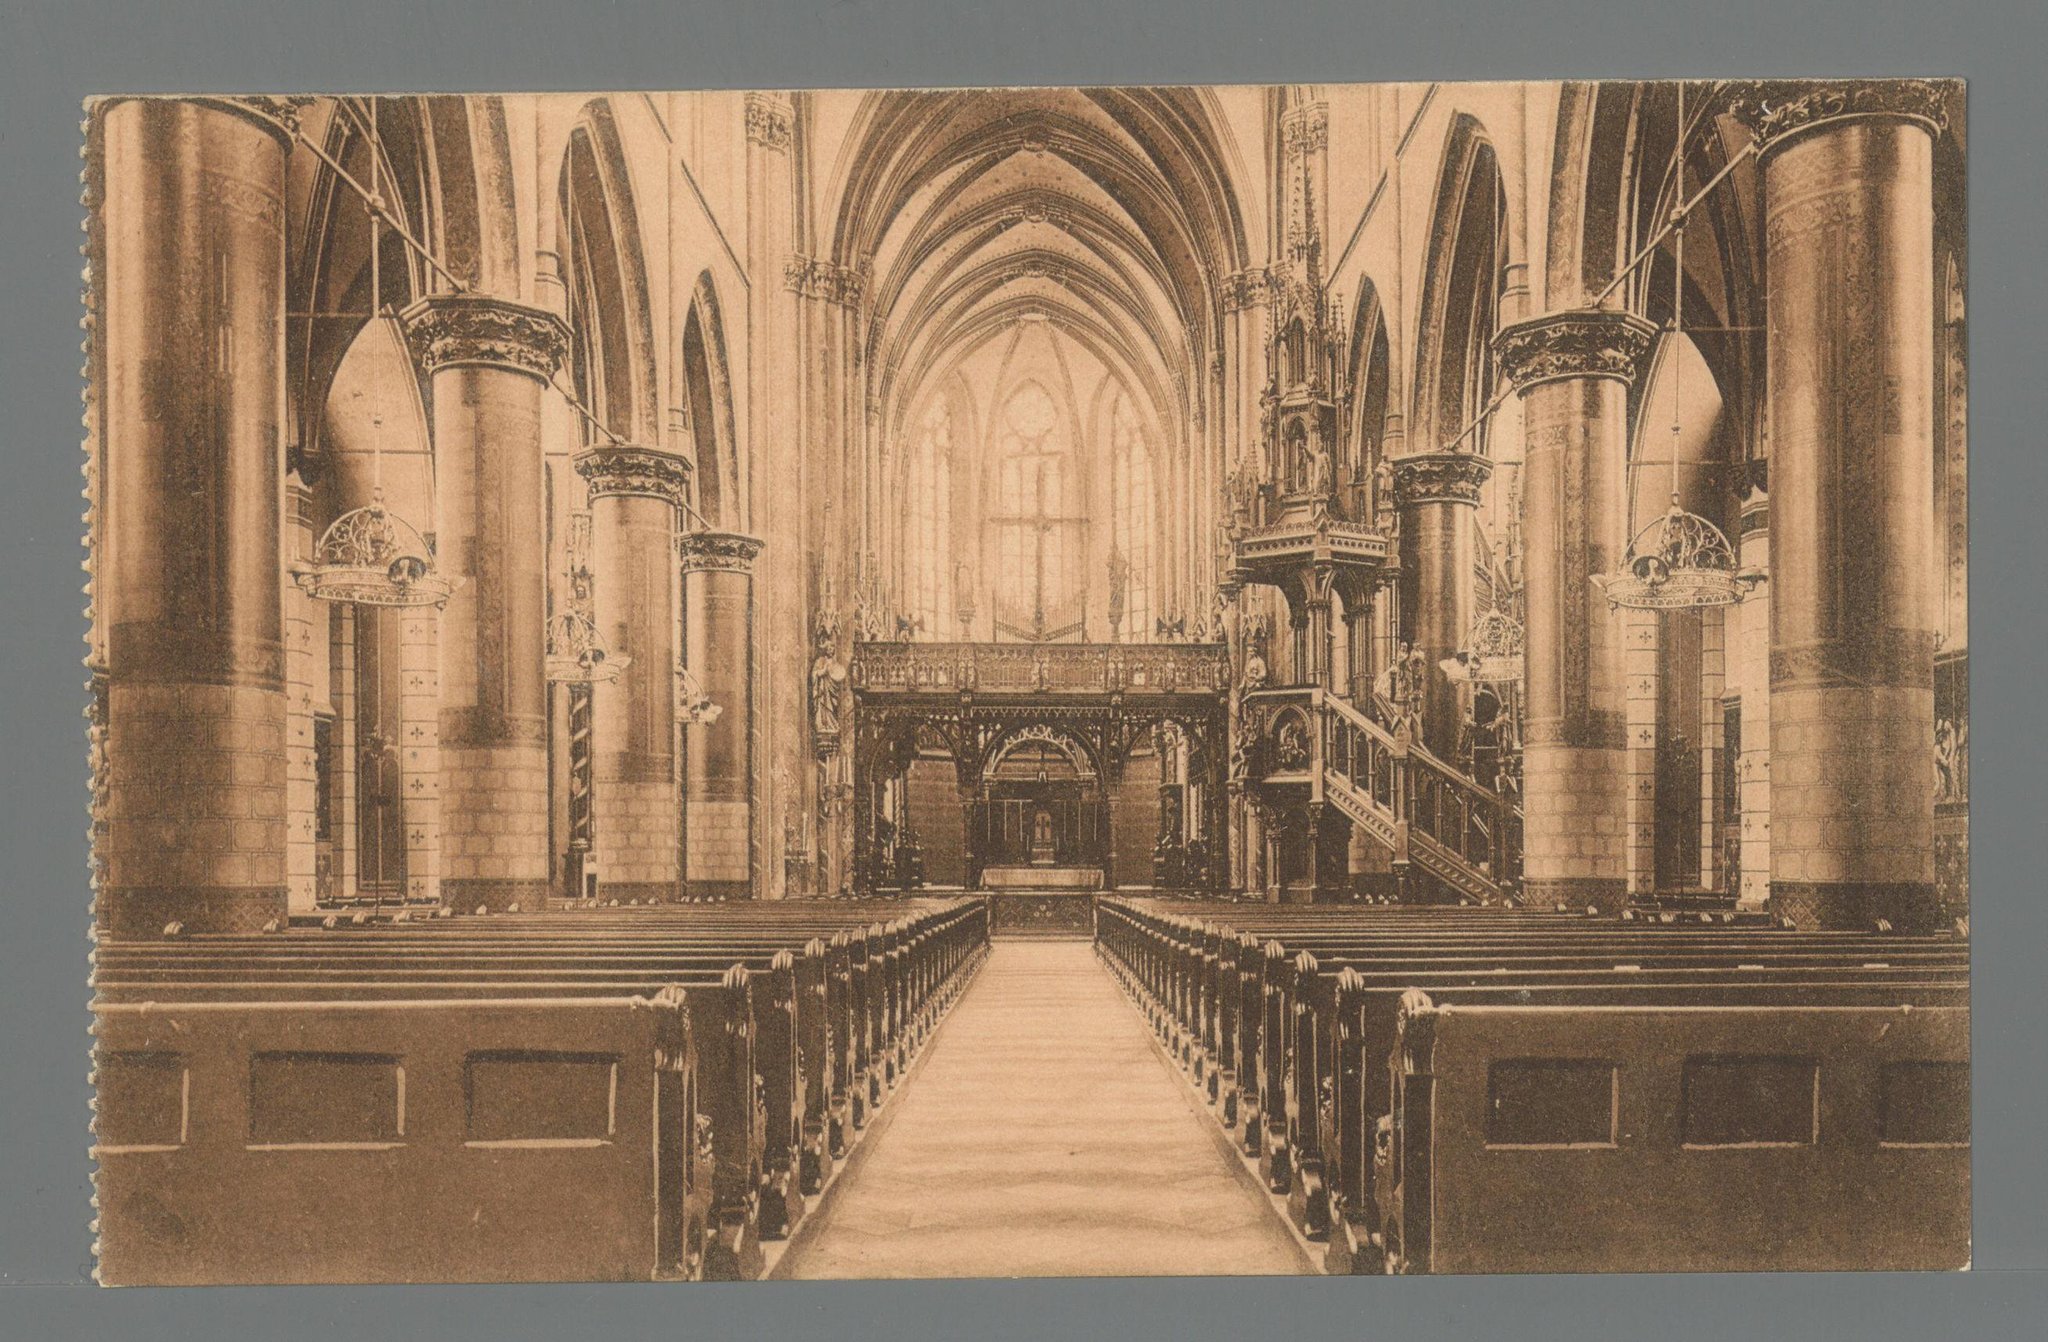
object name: ansichtkaart, prentbriefkaart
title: Interieur der Parochiekerk St. Catharina Kathedraal. Utrecht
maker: Anonymous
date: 1905-1930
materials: cardboard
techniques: photograph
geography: utrecht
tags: interior of church, altar with altar-piece